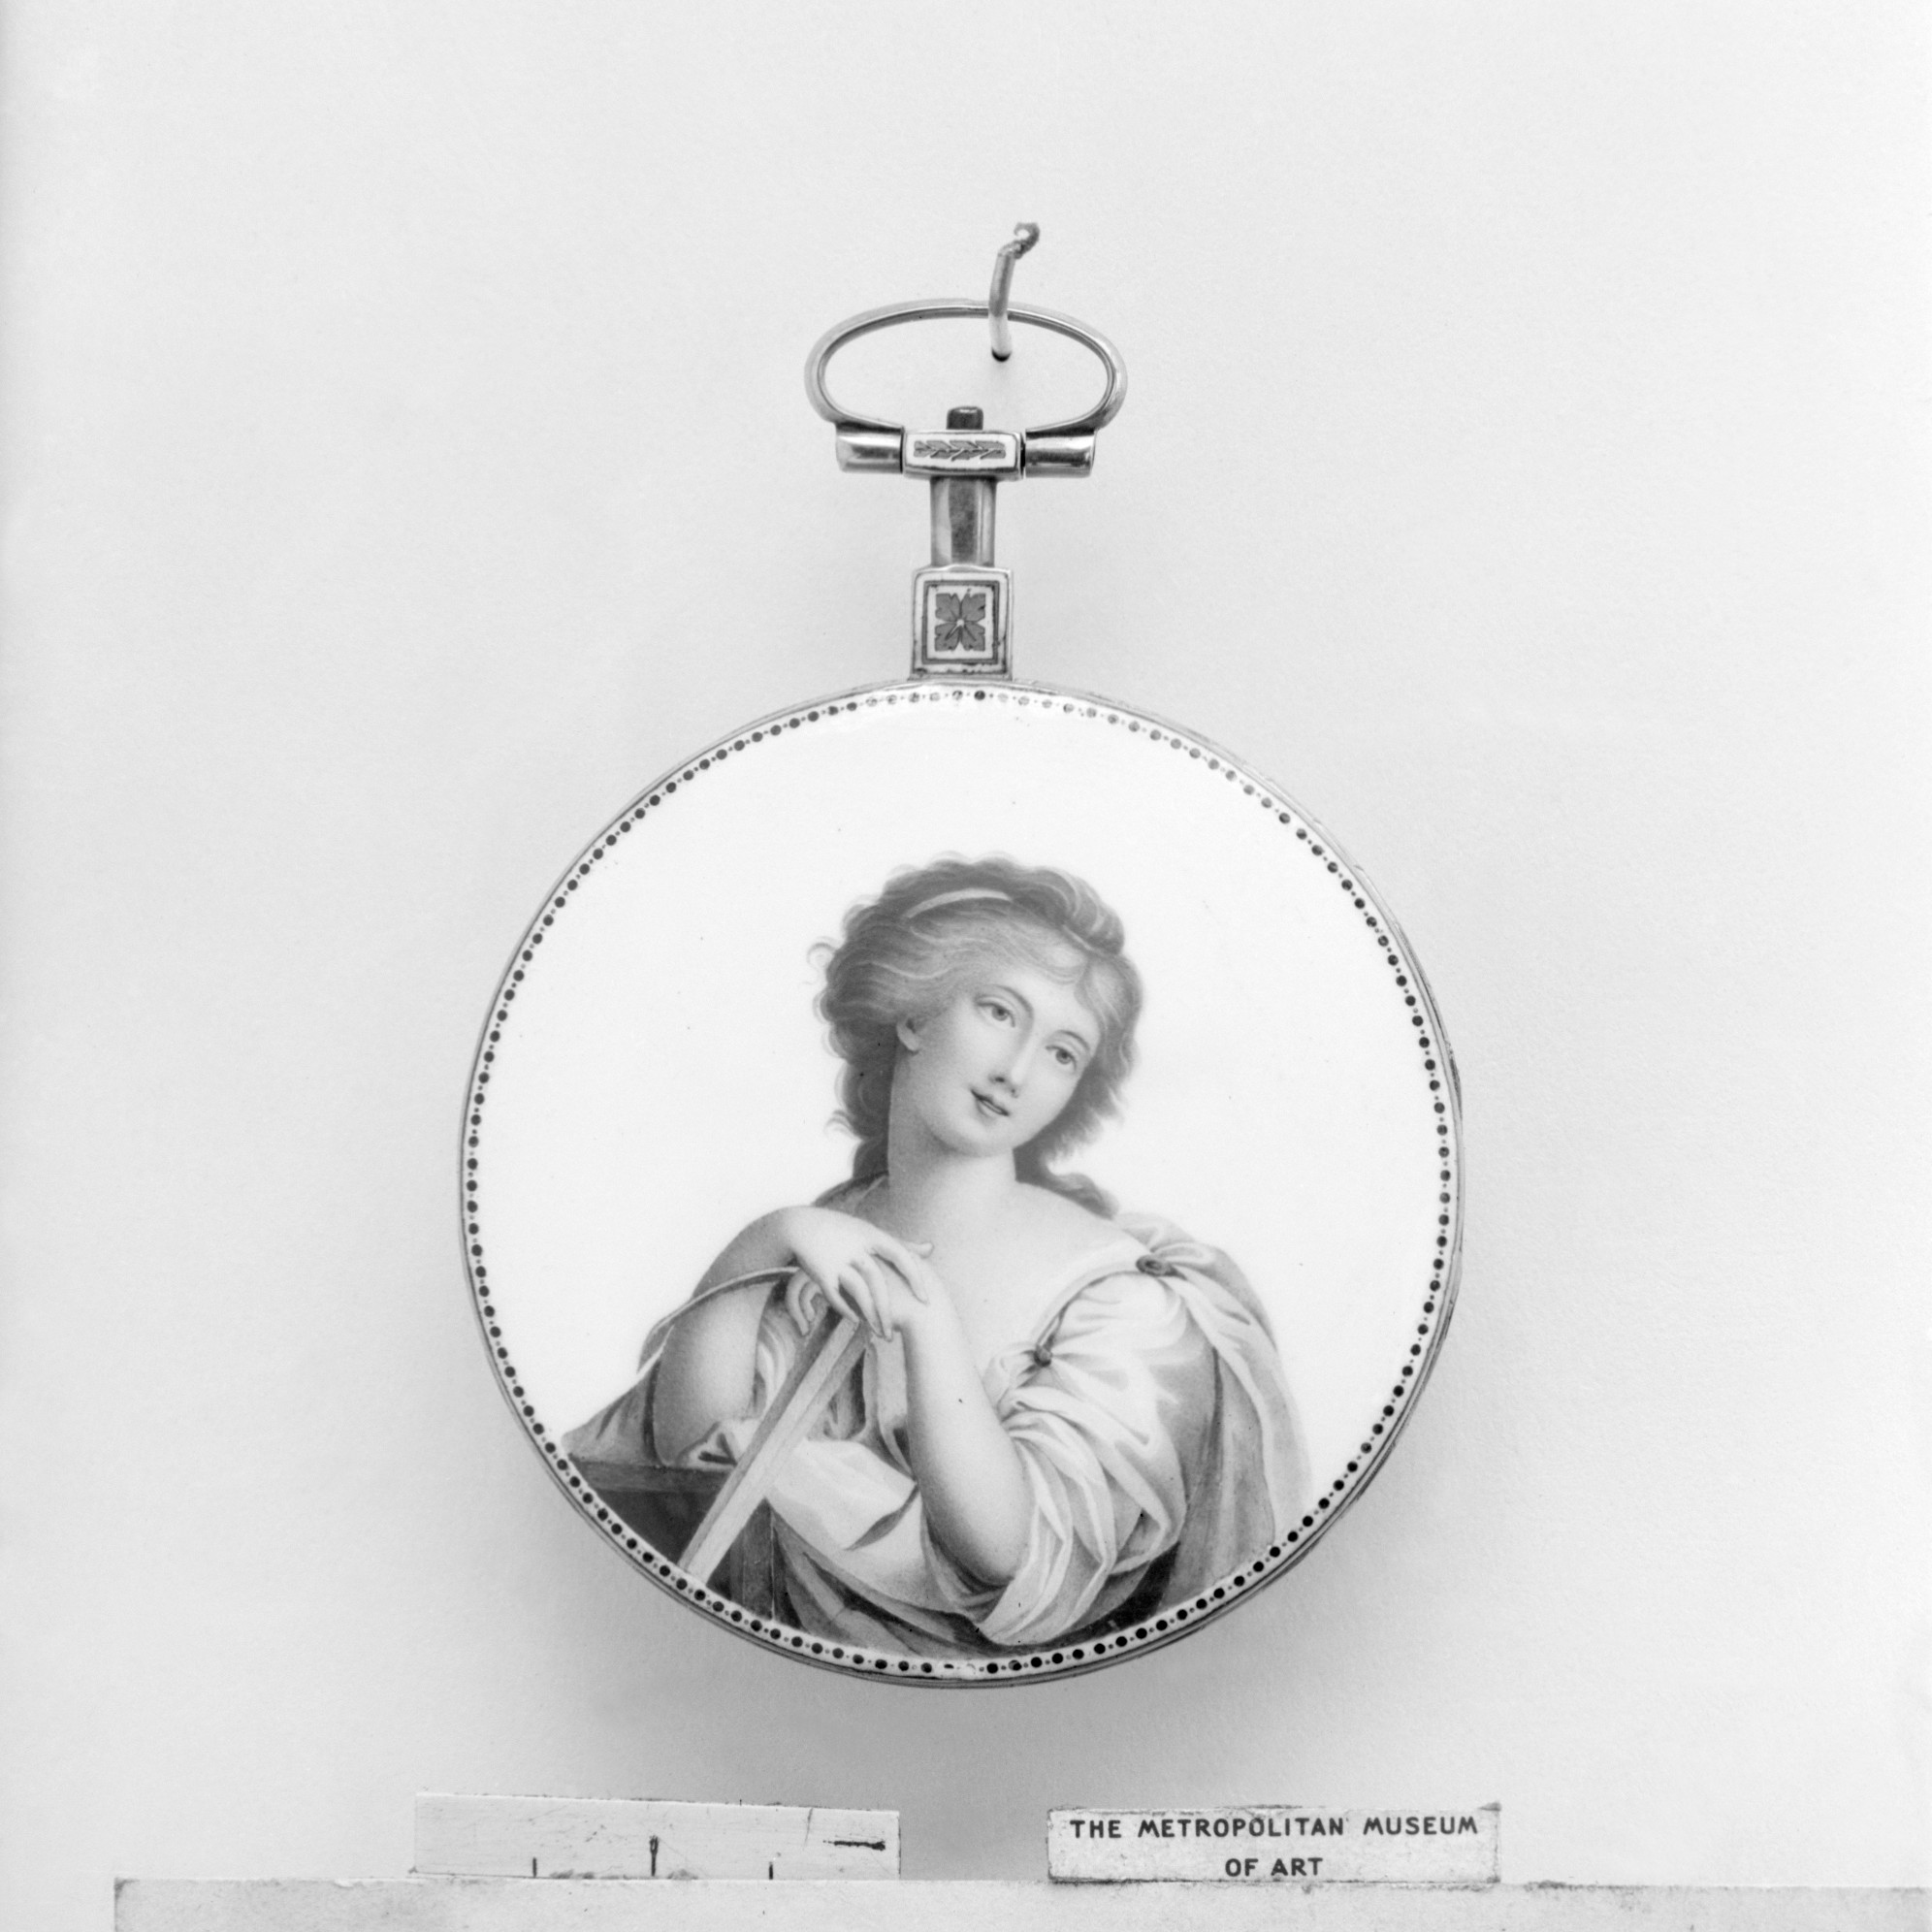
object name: watch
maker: robert robin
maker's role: maker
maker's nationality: french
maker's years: 1749-1799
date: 1790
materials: enamel, metal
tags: portraits,women